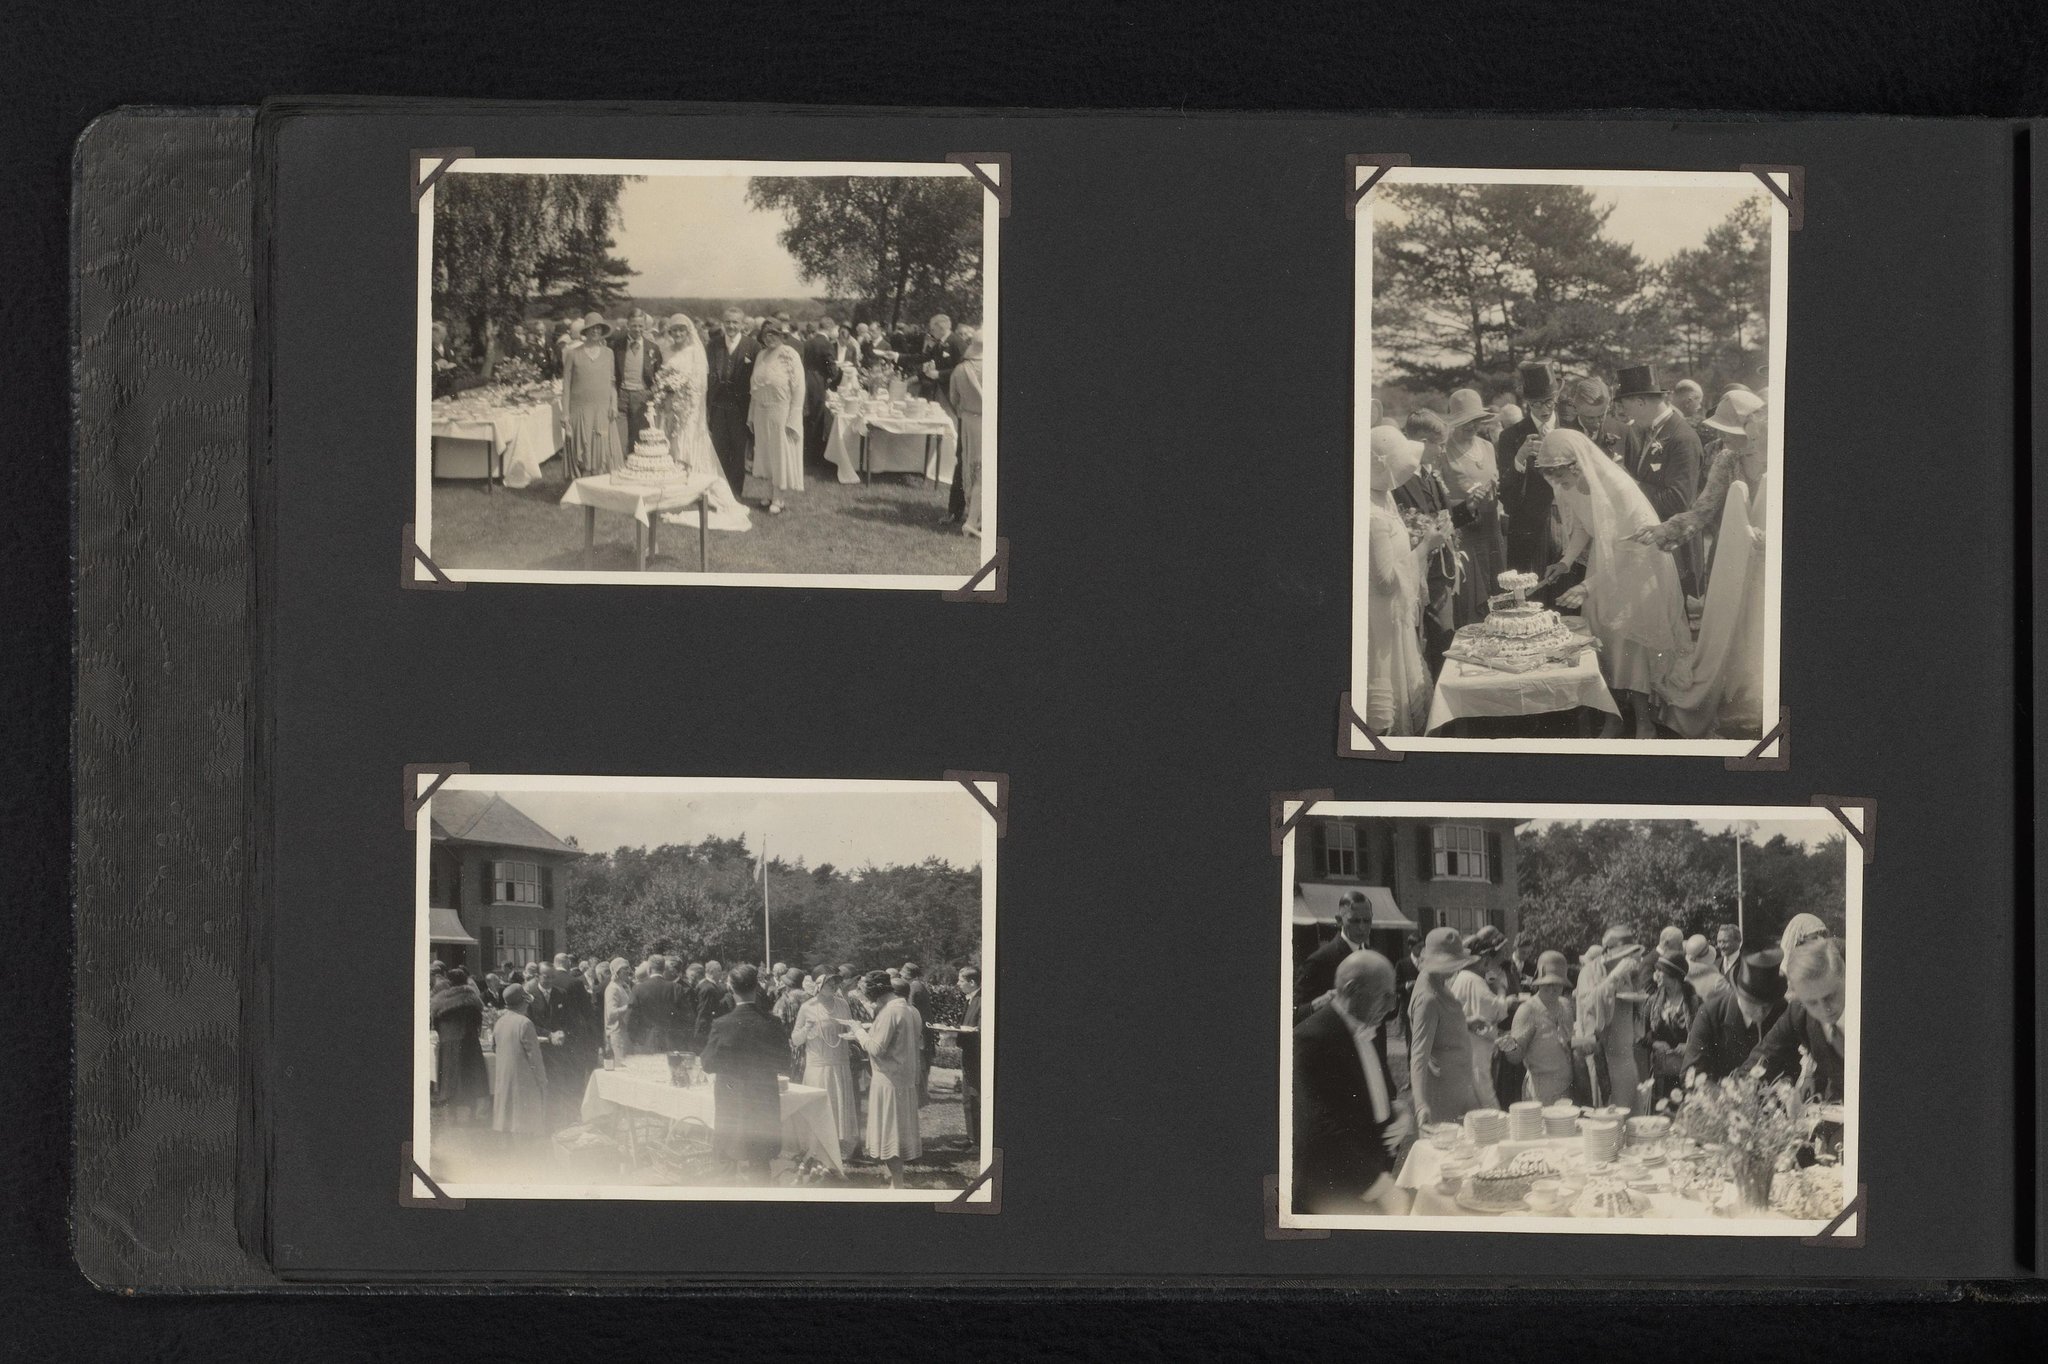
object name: album leaf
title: Vier foto's van het huwelijksfeest van Henricus Petrus Joannes van Ketwich Verschuur en Elize de Beaufort bij landhuis De Hooght, Maarn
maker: hendrik herman van den berg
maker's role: amateurfotograaf, jurist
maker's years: 1875-1944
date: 1929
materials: paper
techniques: gelatin silver print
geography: maarn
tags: amsterdam, the hague, wedding feast, wedding meal, garden, bride and groom in wedding-dress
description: Deze foto's maken deel uit van een album.